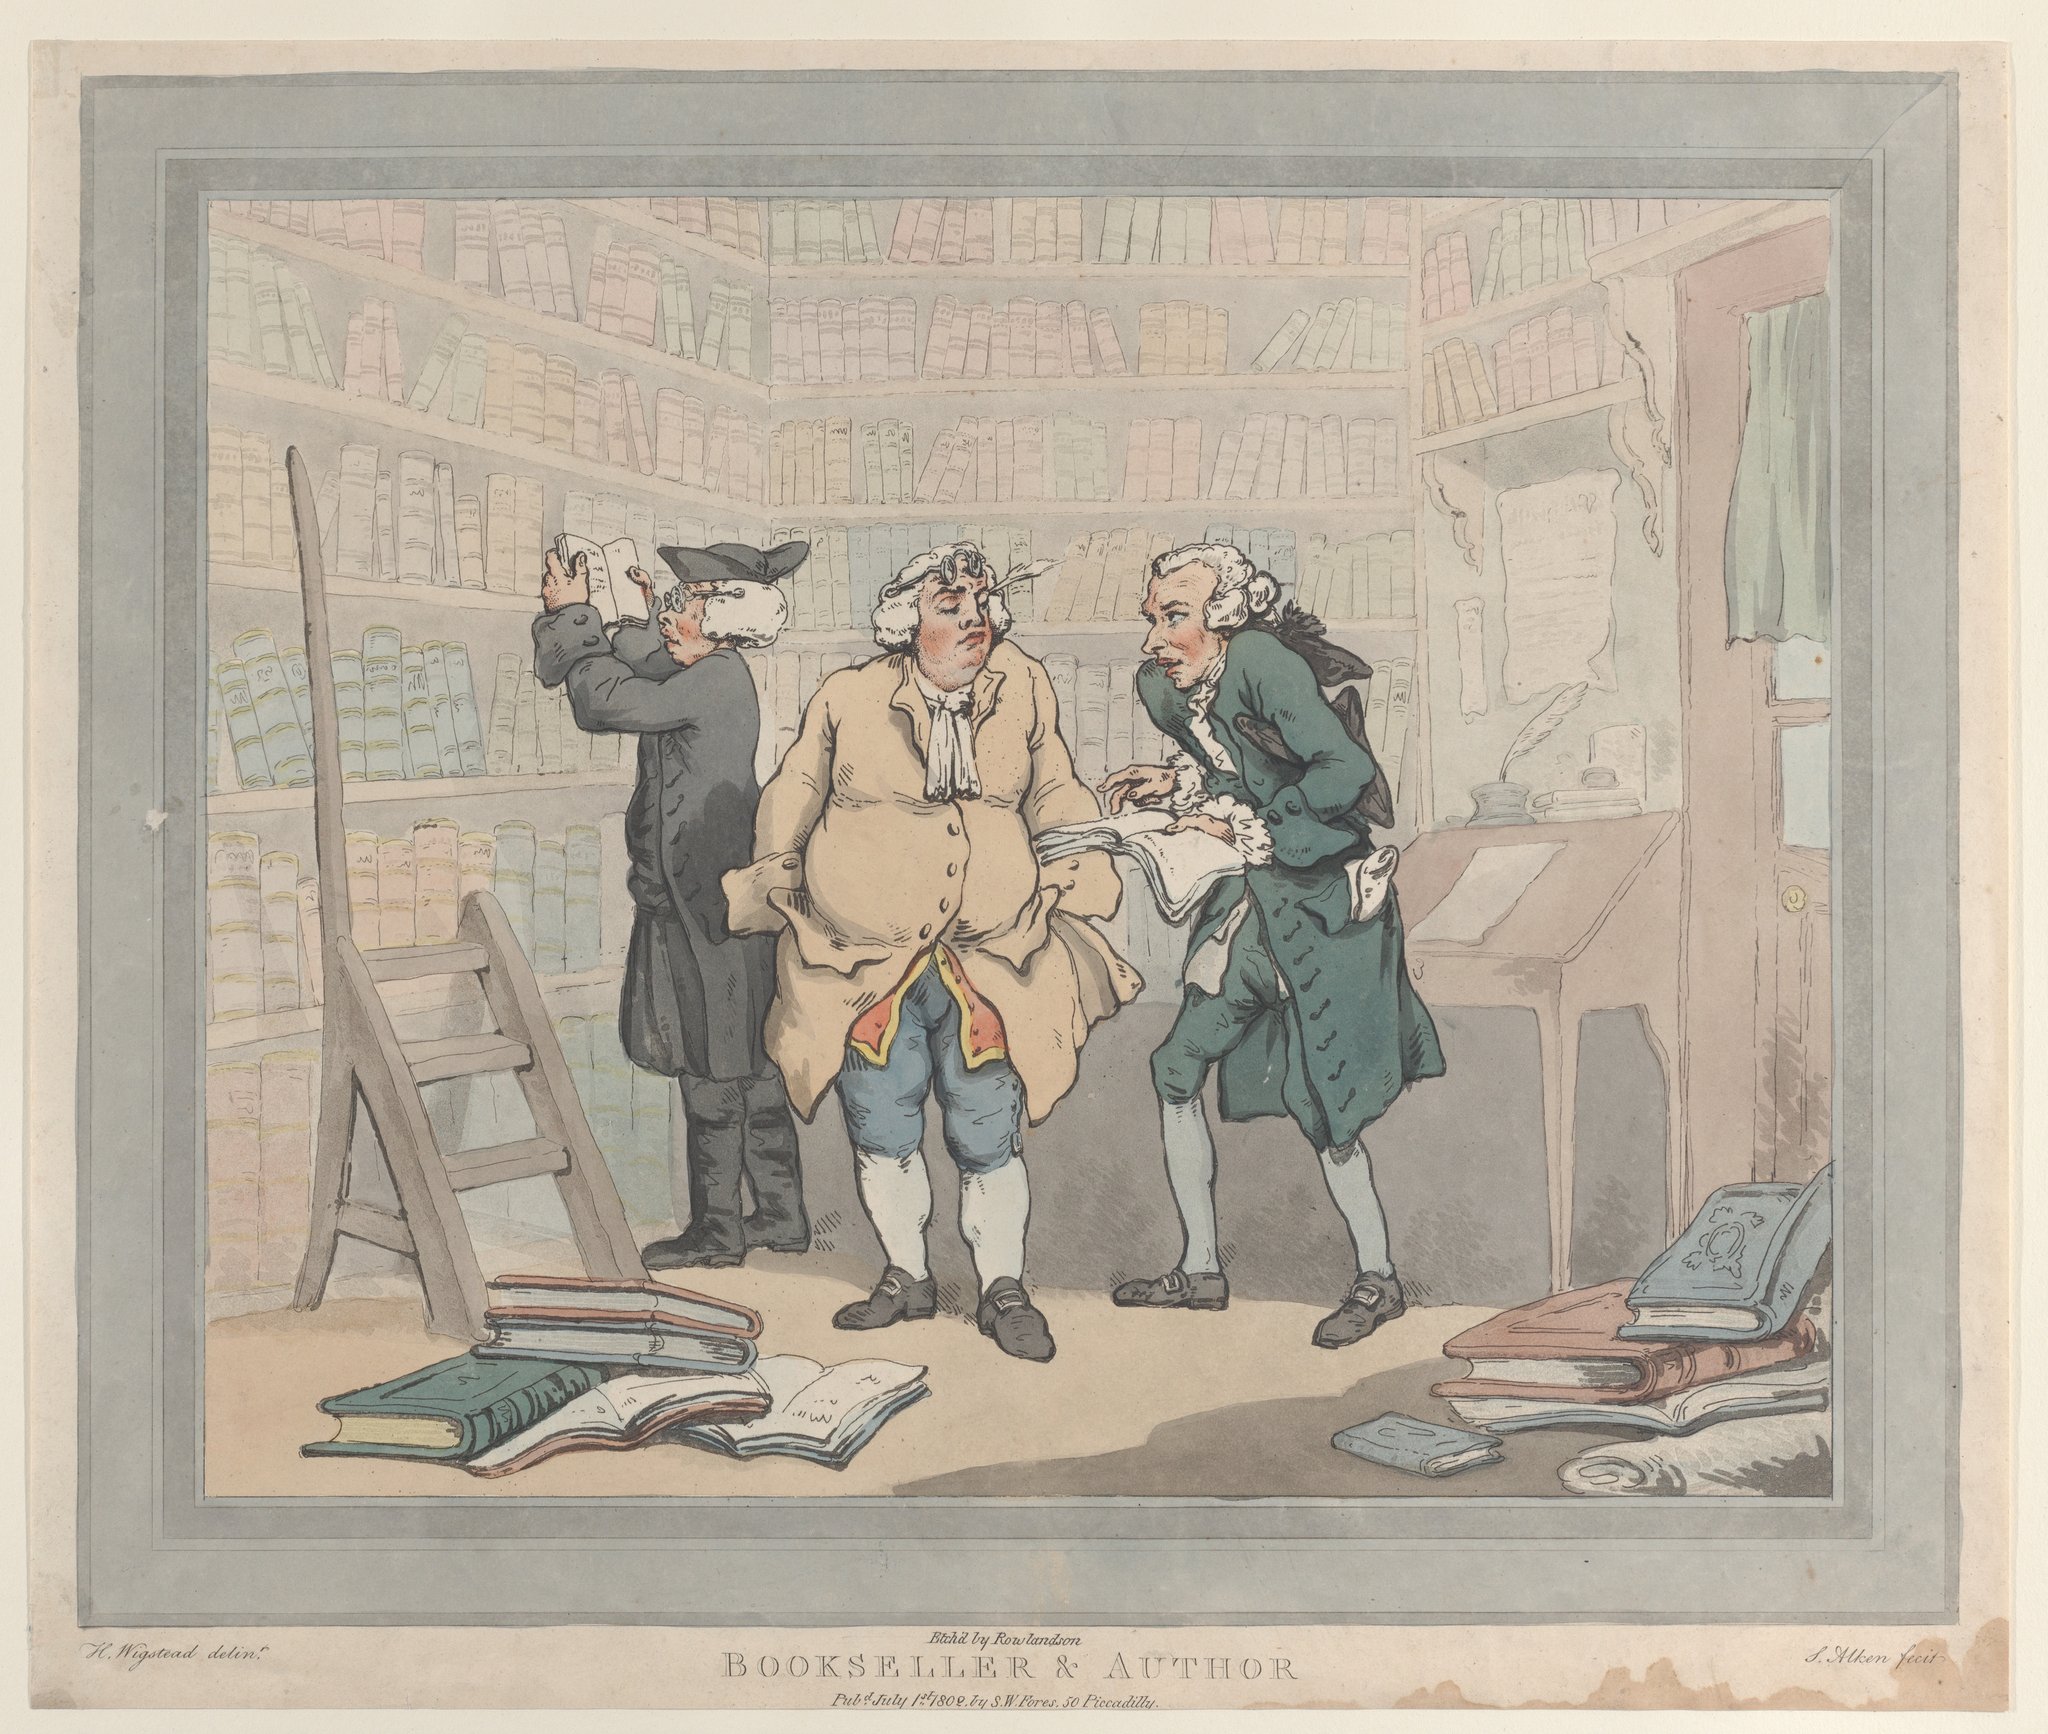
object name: print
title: Bookseller and Author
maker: thomas rowlandson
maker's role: artist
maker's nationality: british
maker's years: 1757-1827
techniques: aquatint, etching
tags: satire,books,men